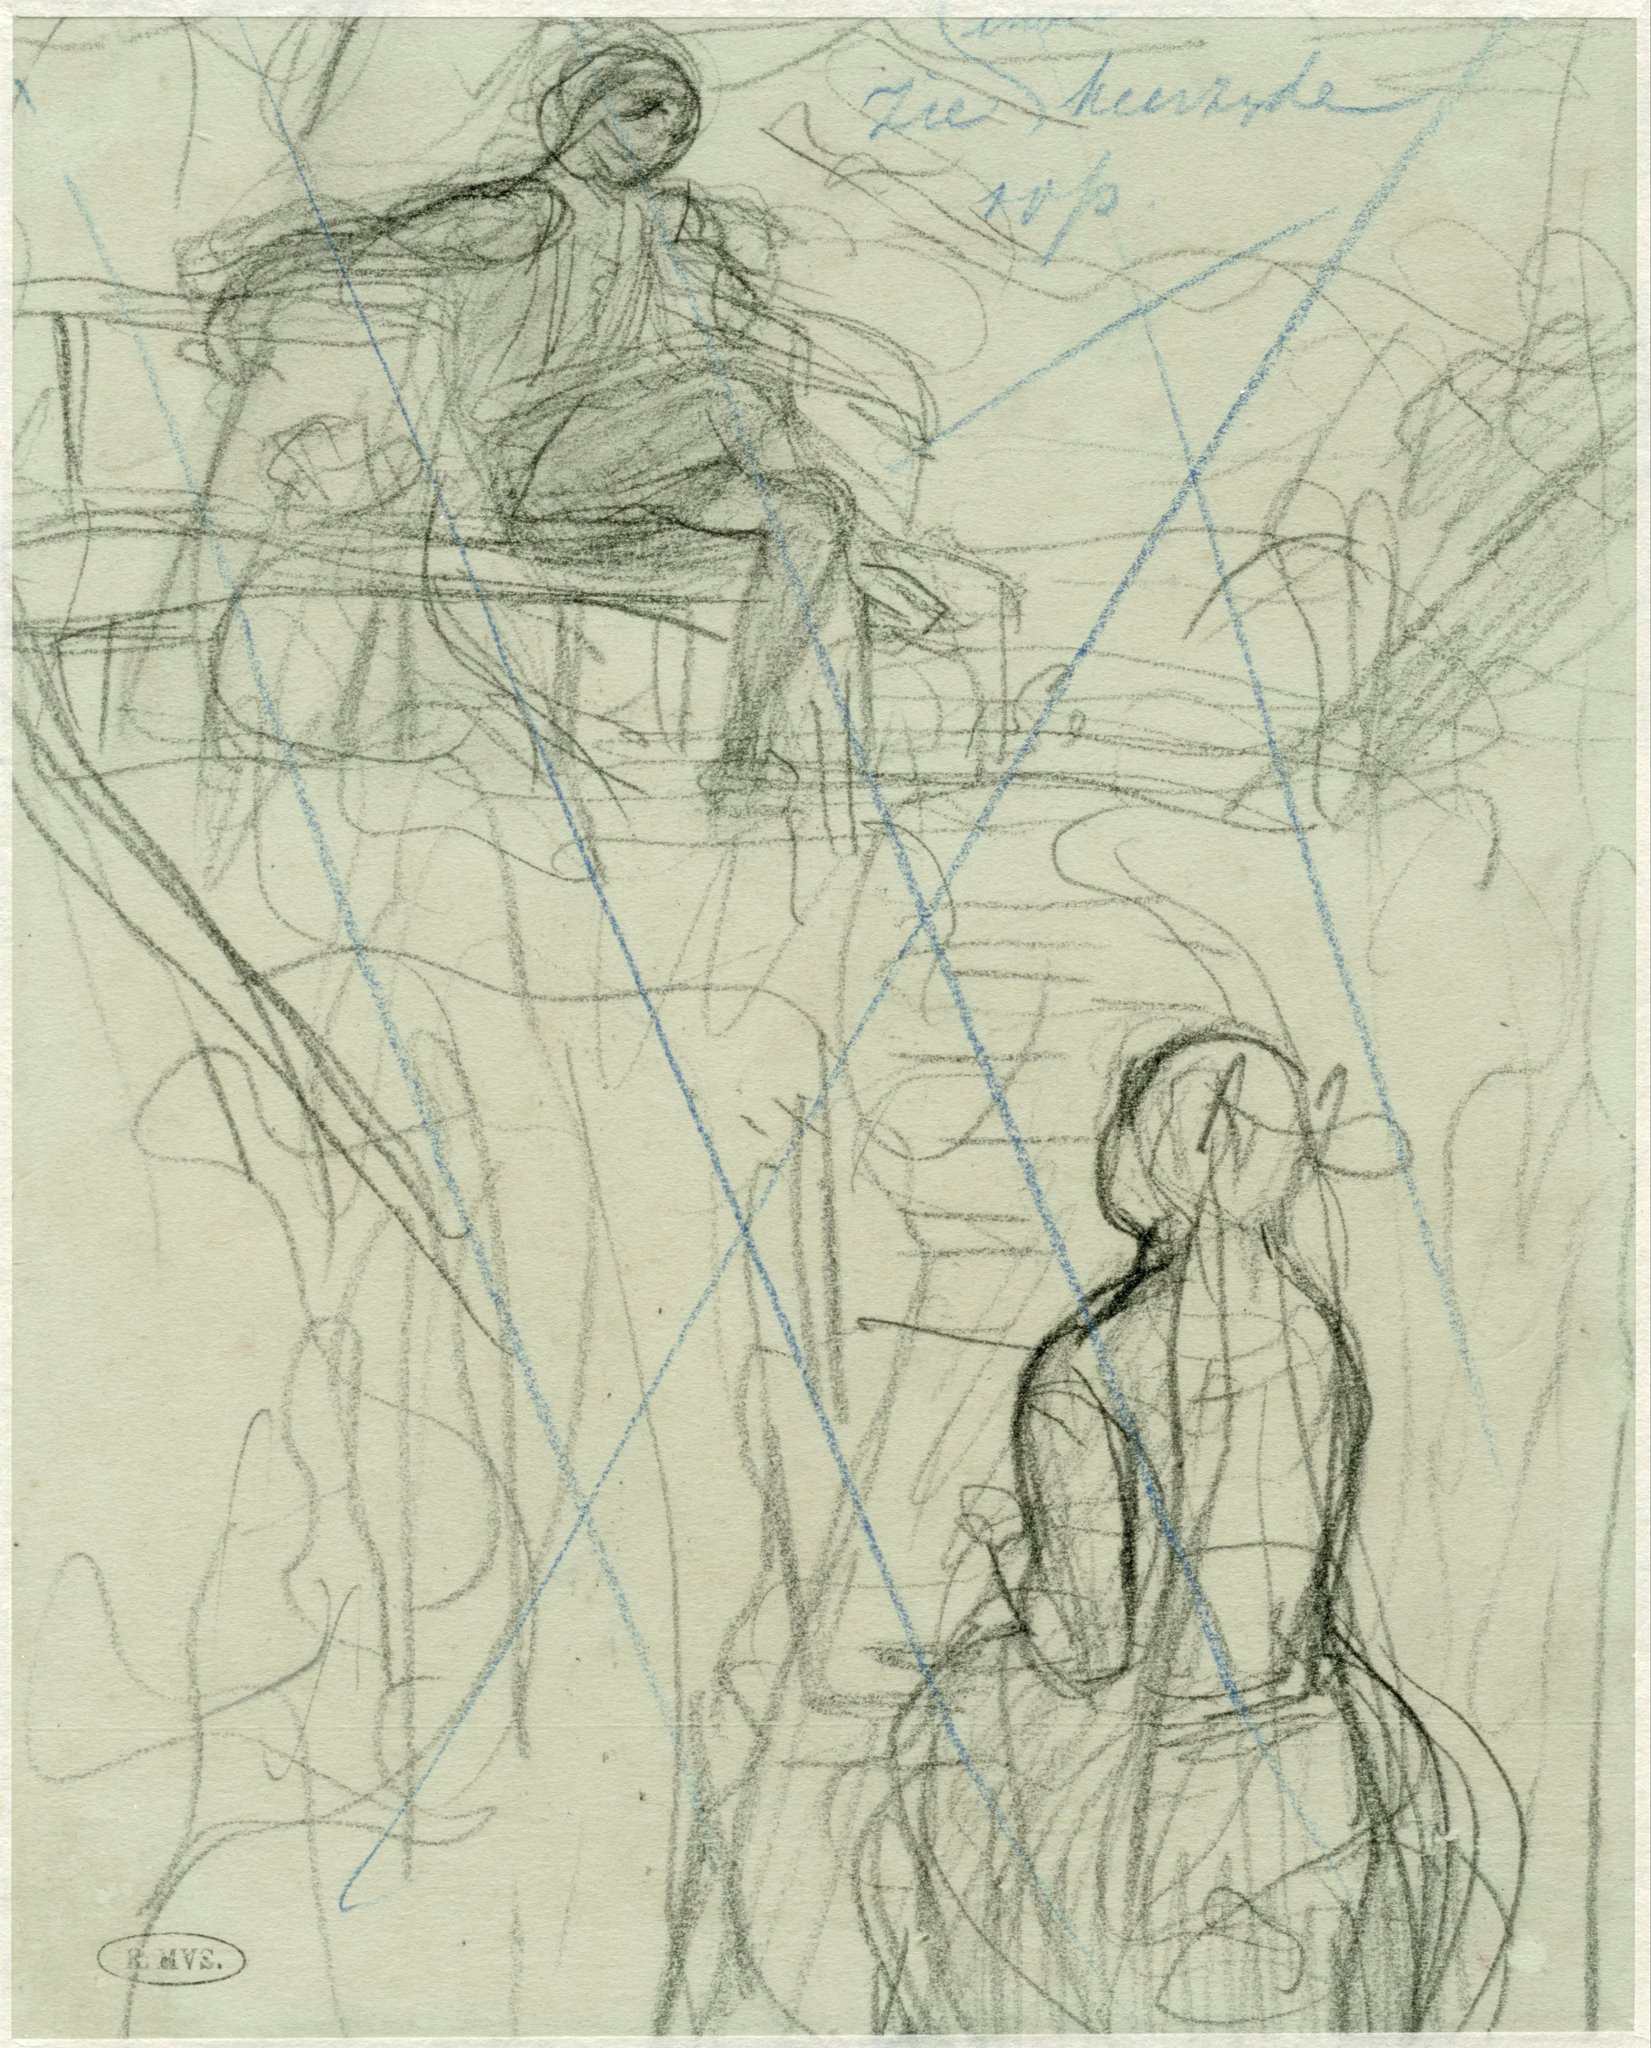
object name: drawing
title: Doorgekraste schetsen van een staand en een zittend figuur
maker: august allebé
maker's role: draughtsman, print maker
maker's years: 1838-1927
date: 1848-1927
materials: chalk, paper